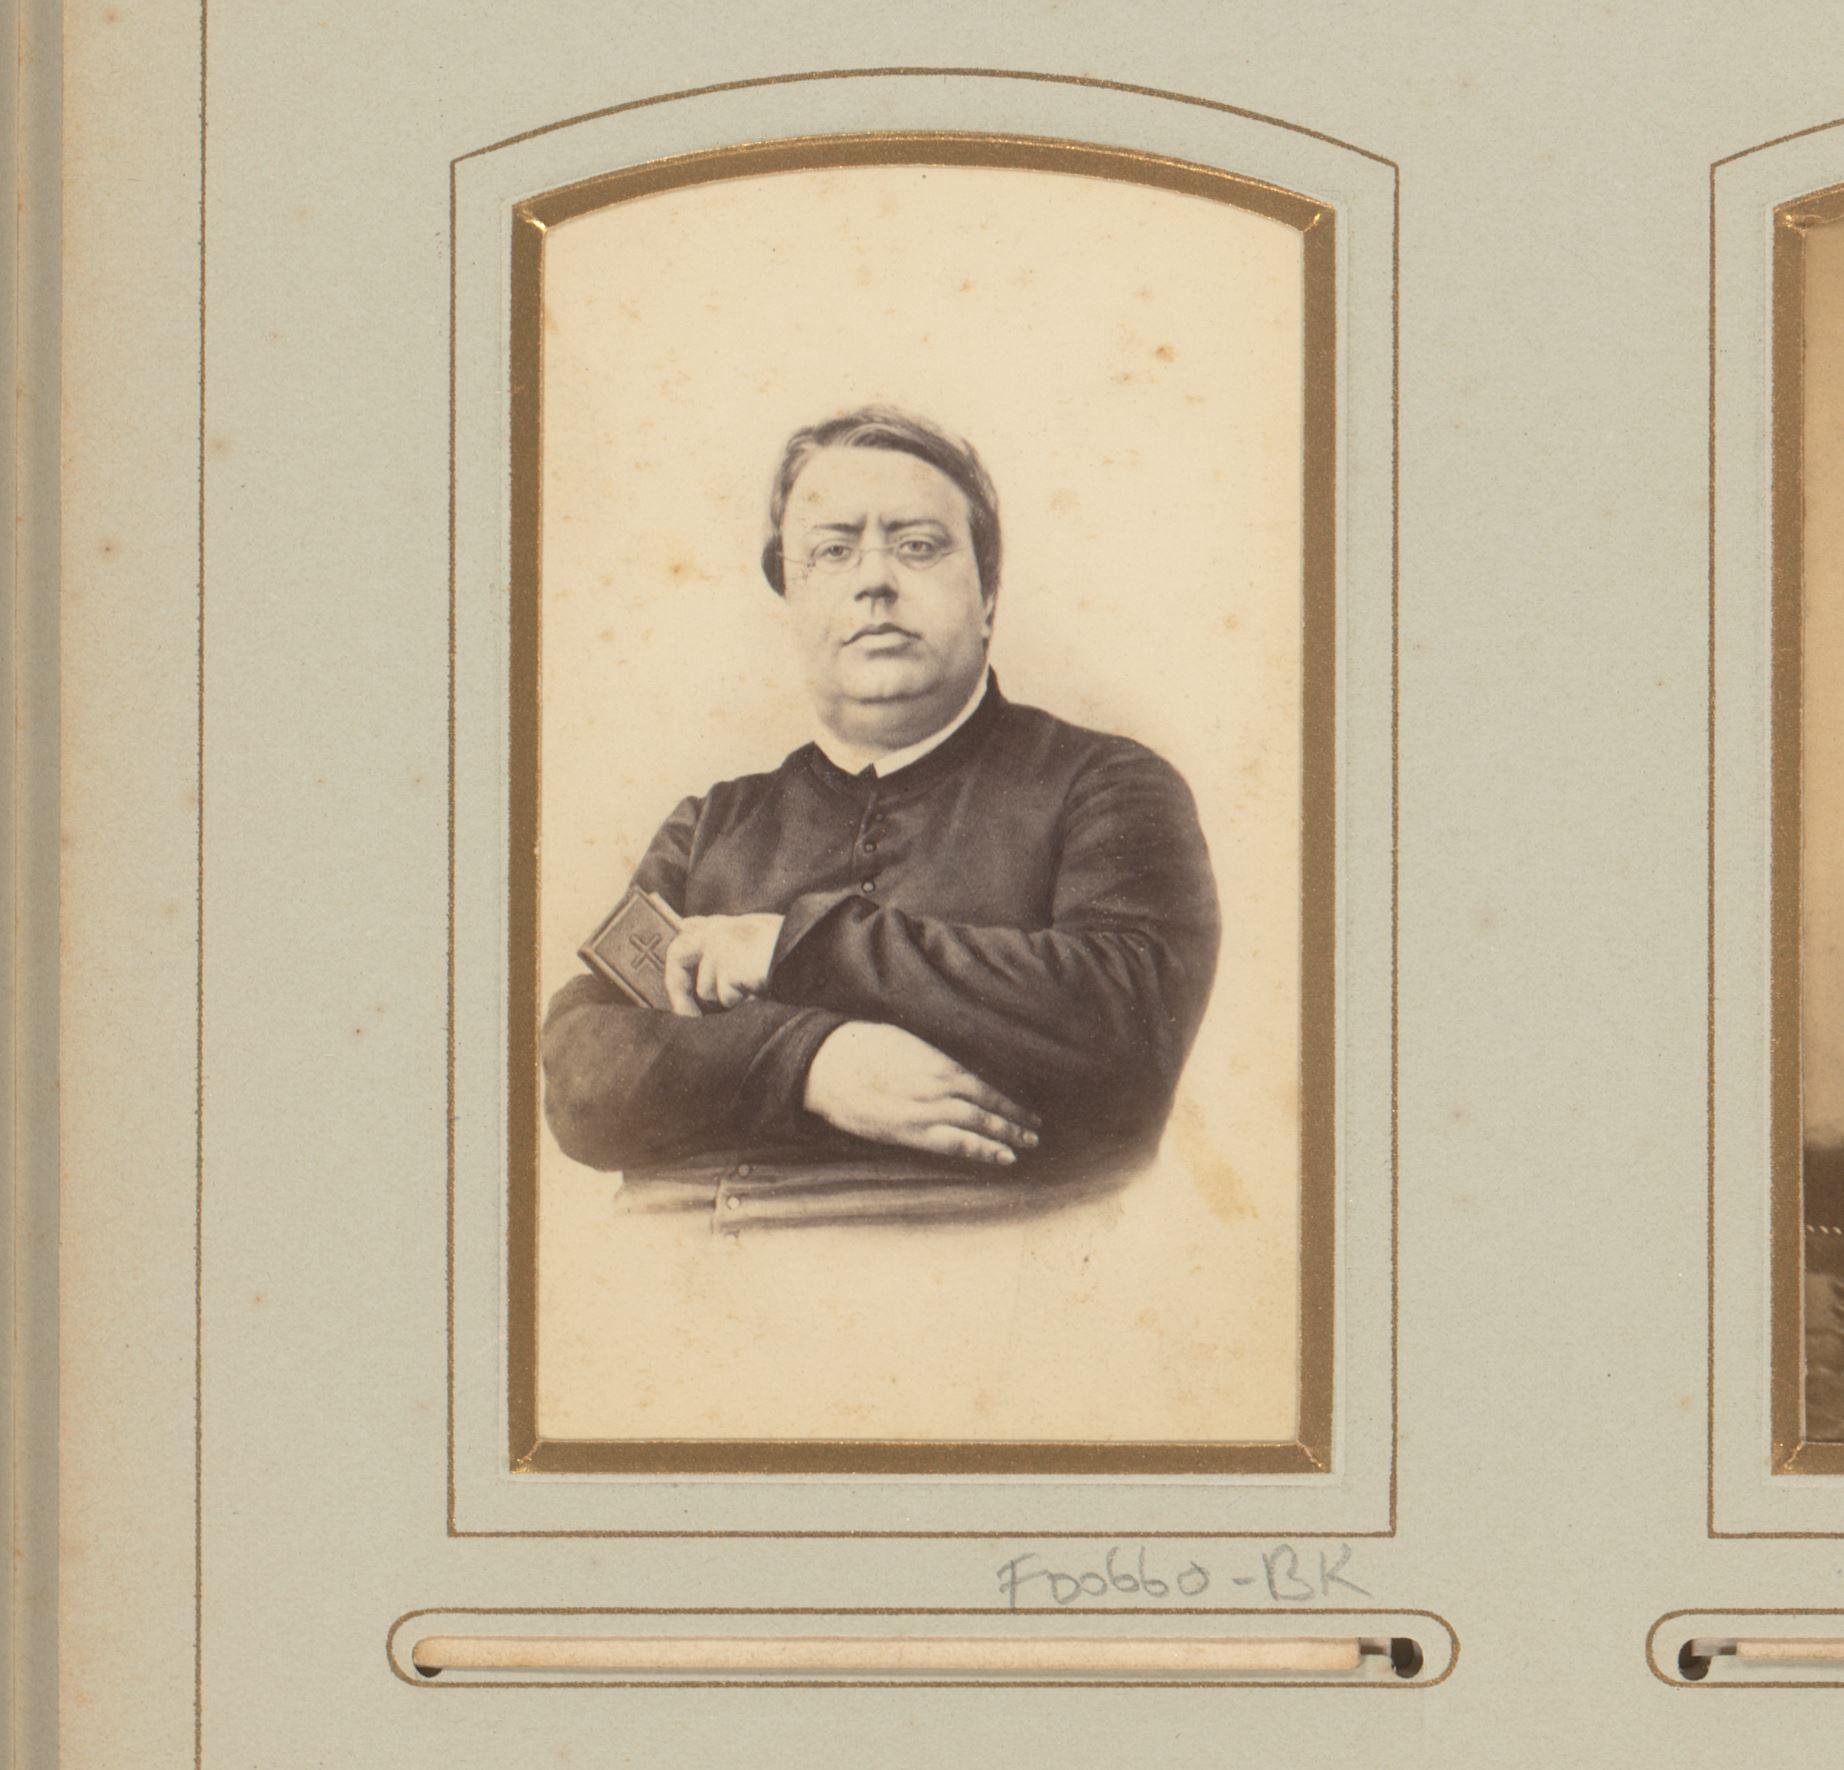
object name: album leaf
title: Portret van een geestelijke met kerkboek in de hand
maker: césar mitkiewicz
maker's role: fotograaf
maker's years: 1836-1871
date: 1860-1900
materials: cardboard, photographic support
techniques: albumen print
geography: brussels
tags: eyeglasses, spectacles, theologian, historical persons, reading the bible or other religious books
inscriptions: inscription: ‘Cesar Mitkiewicz/ Photographe/ 51, Rue de la Montagne, 51/ Bruxelles’